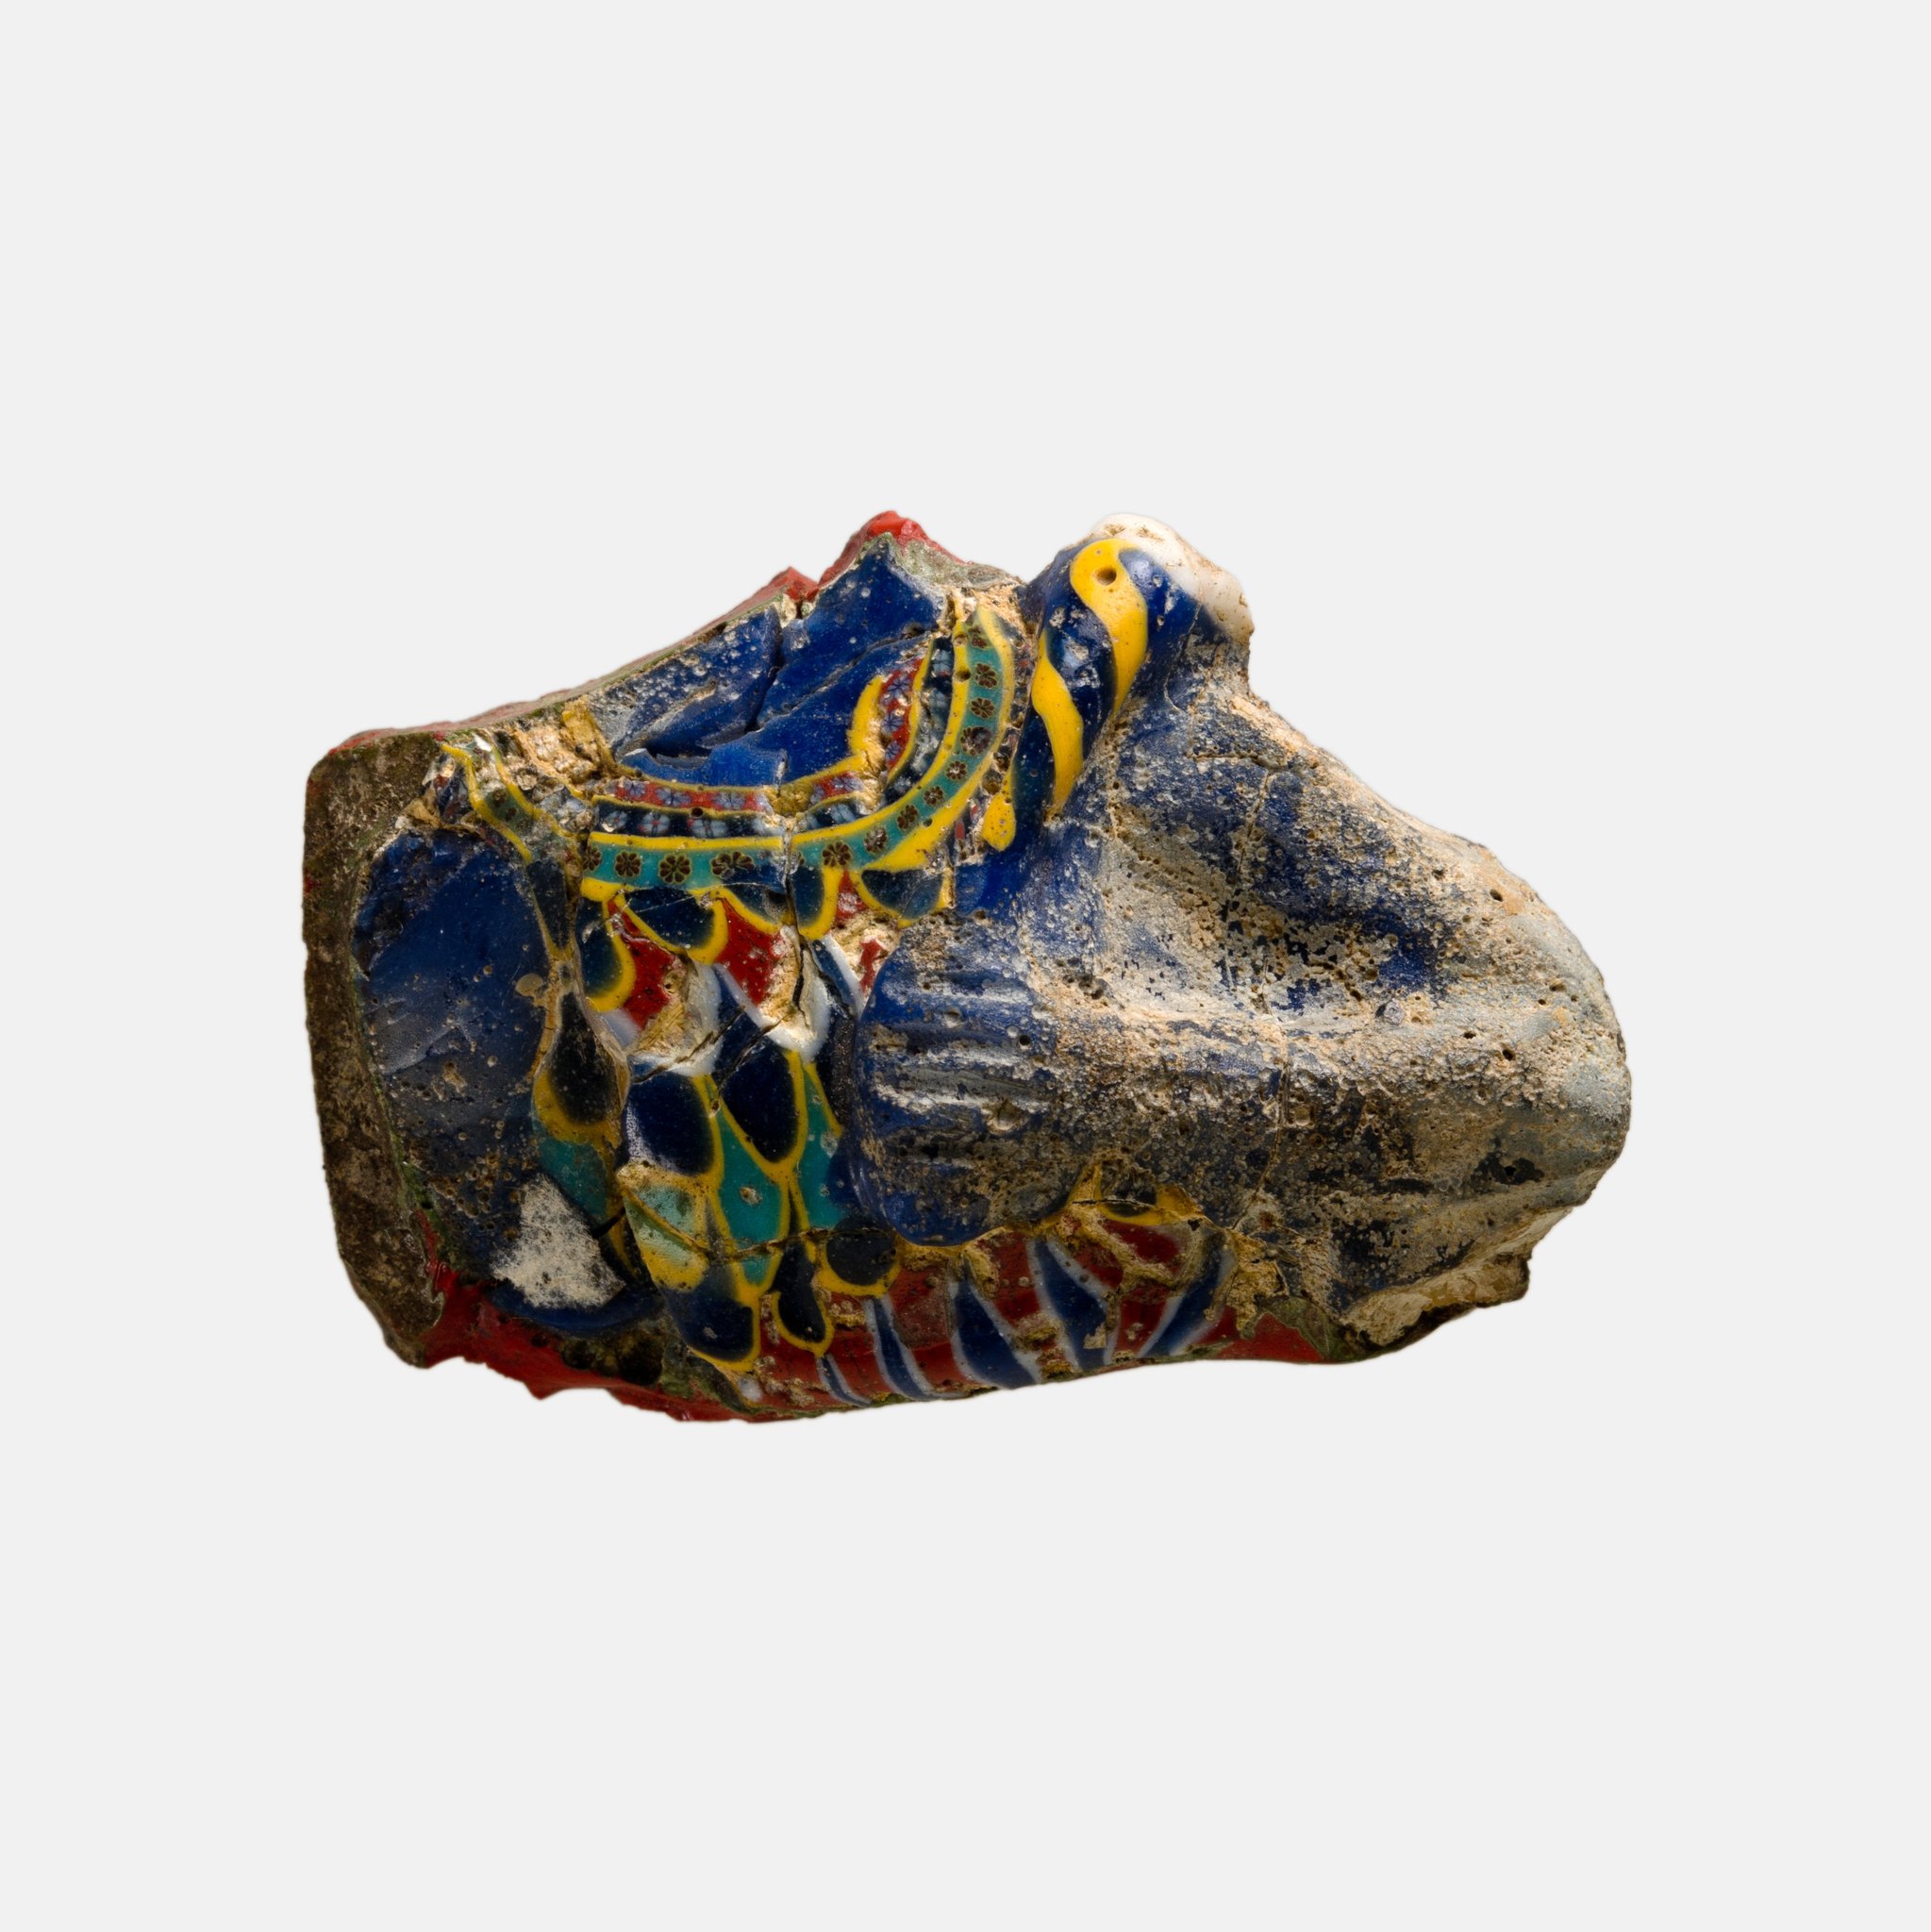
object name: inlay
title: High relief inlay fragment, frontal bust of a god in a feather garment and holding a scepter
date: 200 BCE-100 CE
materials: glass